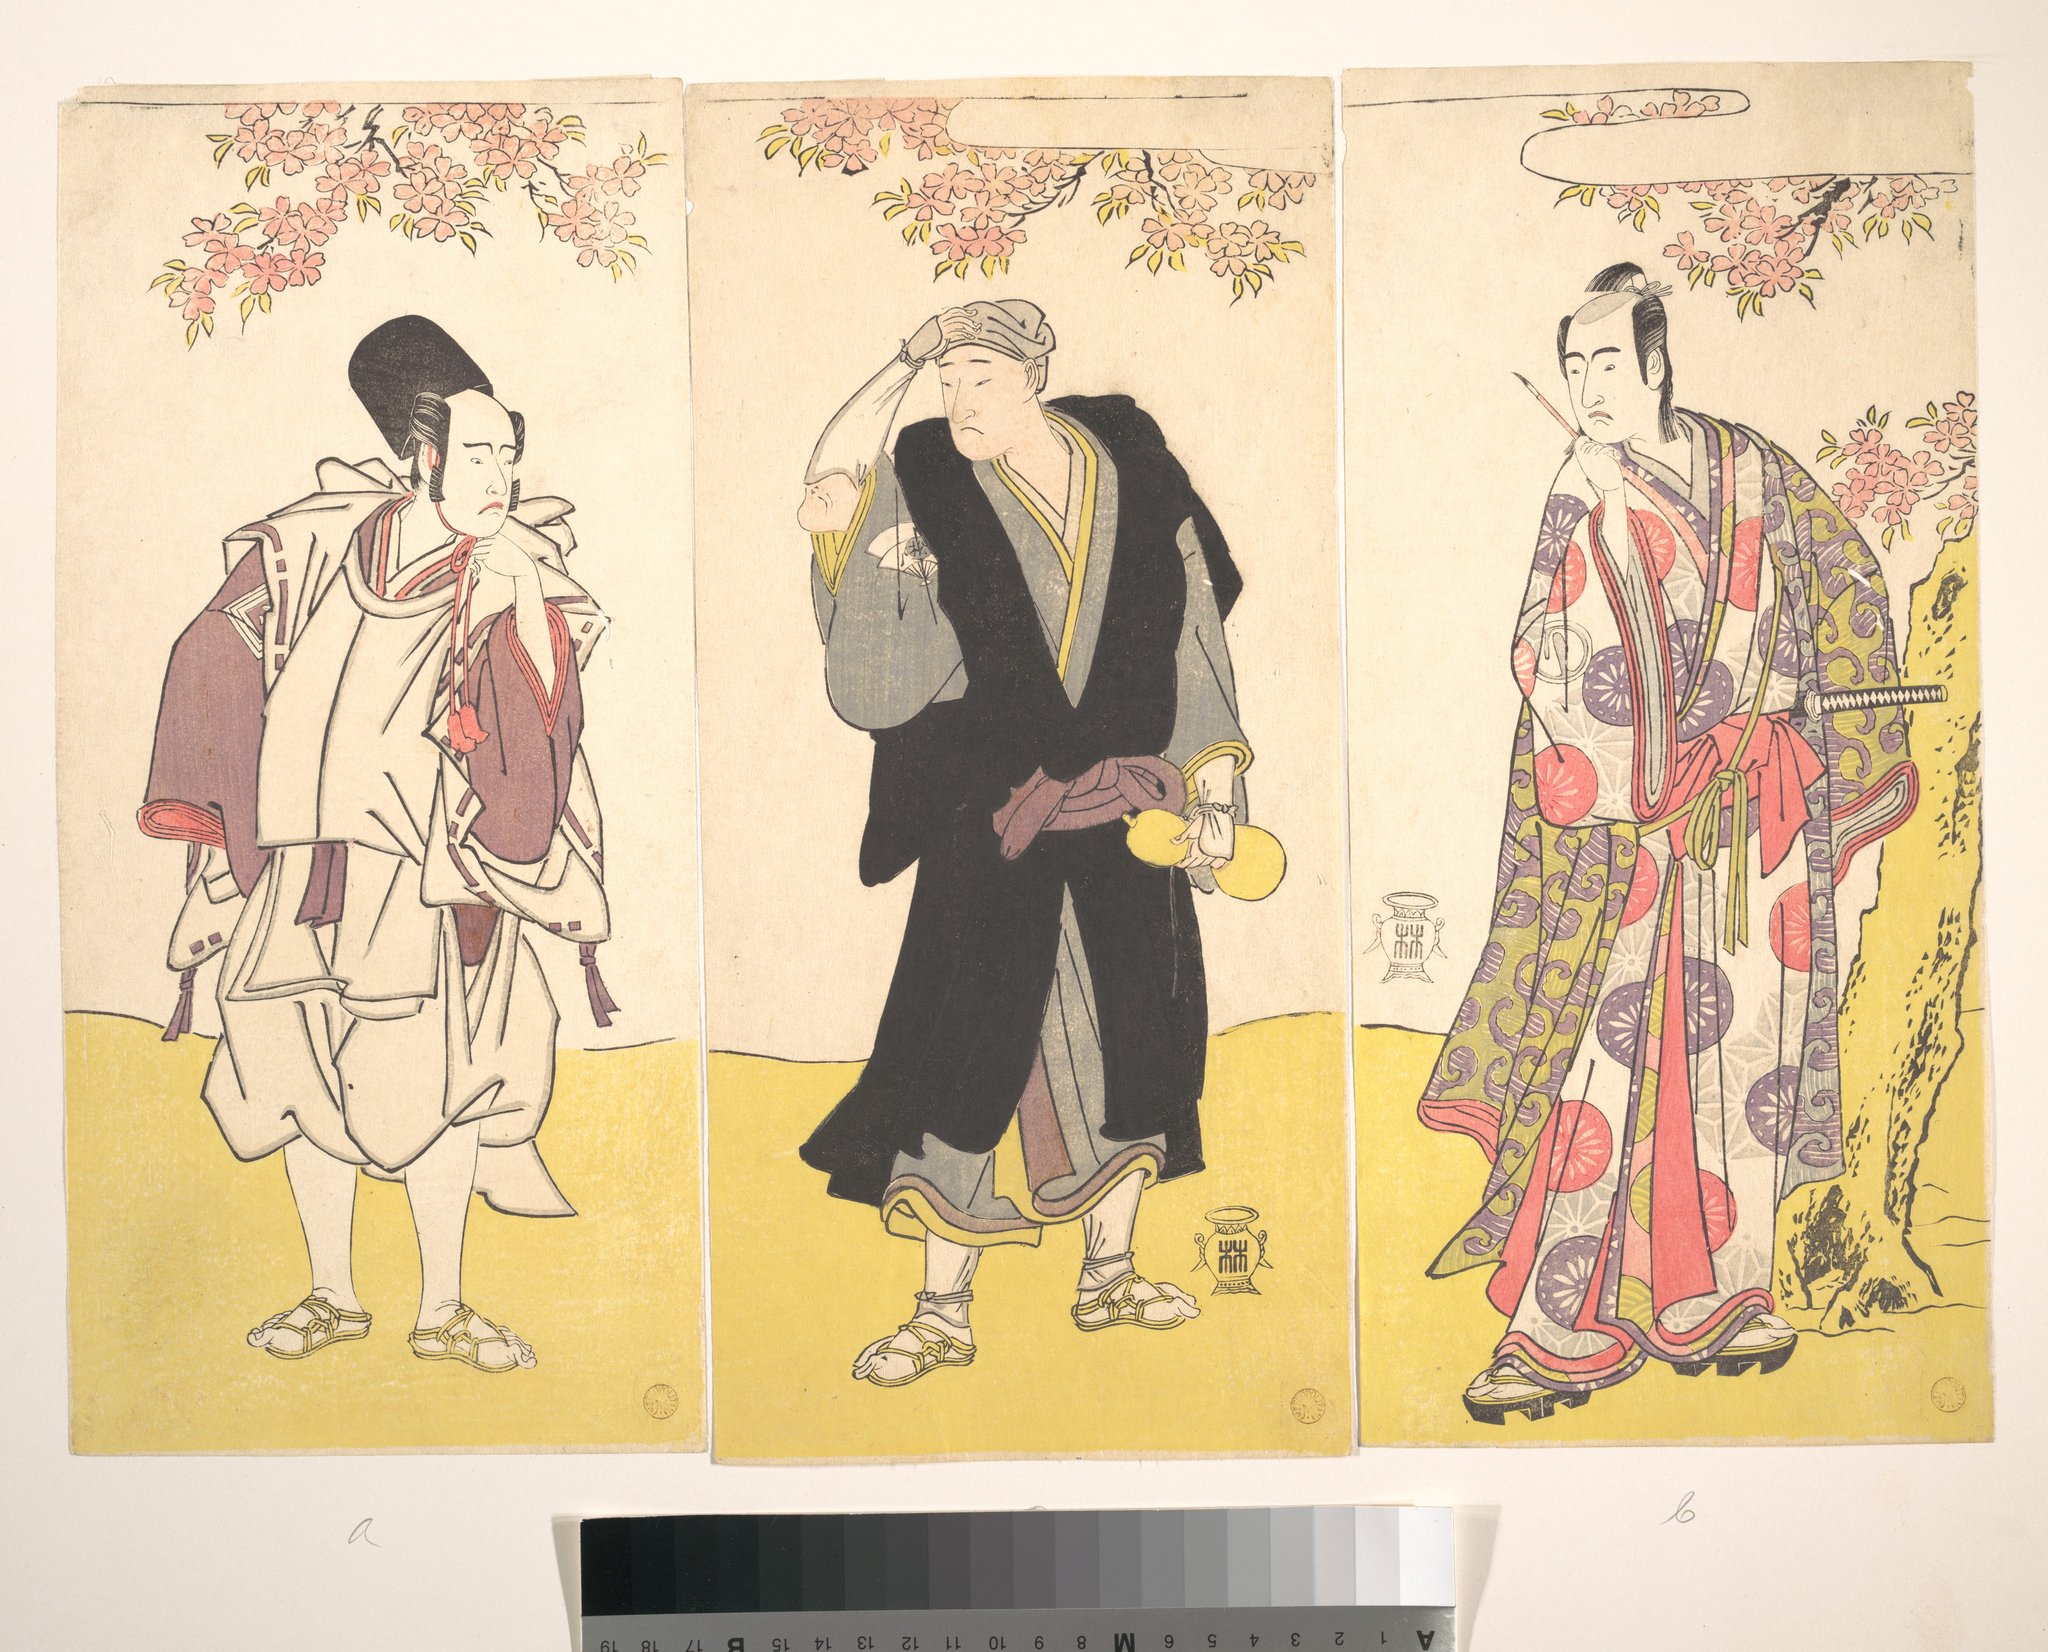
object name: woodblock print nishiki e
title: Kabuki Actors Ichikawa Yaozō III, Onoe Matsusuke I, and Sawamura Sōjūrō III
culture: japanese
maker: katsukawa shunshō 勝川春章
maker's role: artist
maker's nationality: japanese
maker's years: 1726-1792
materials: ink, paper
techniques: nishiki e, woodblock print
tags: men,actors